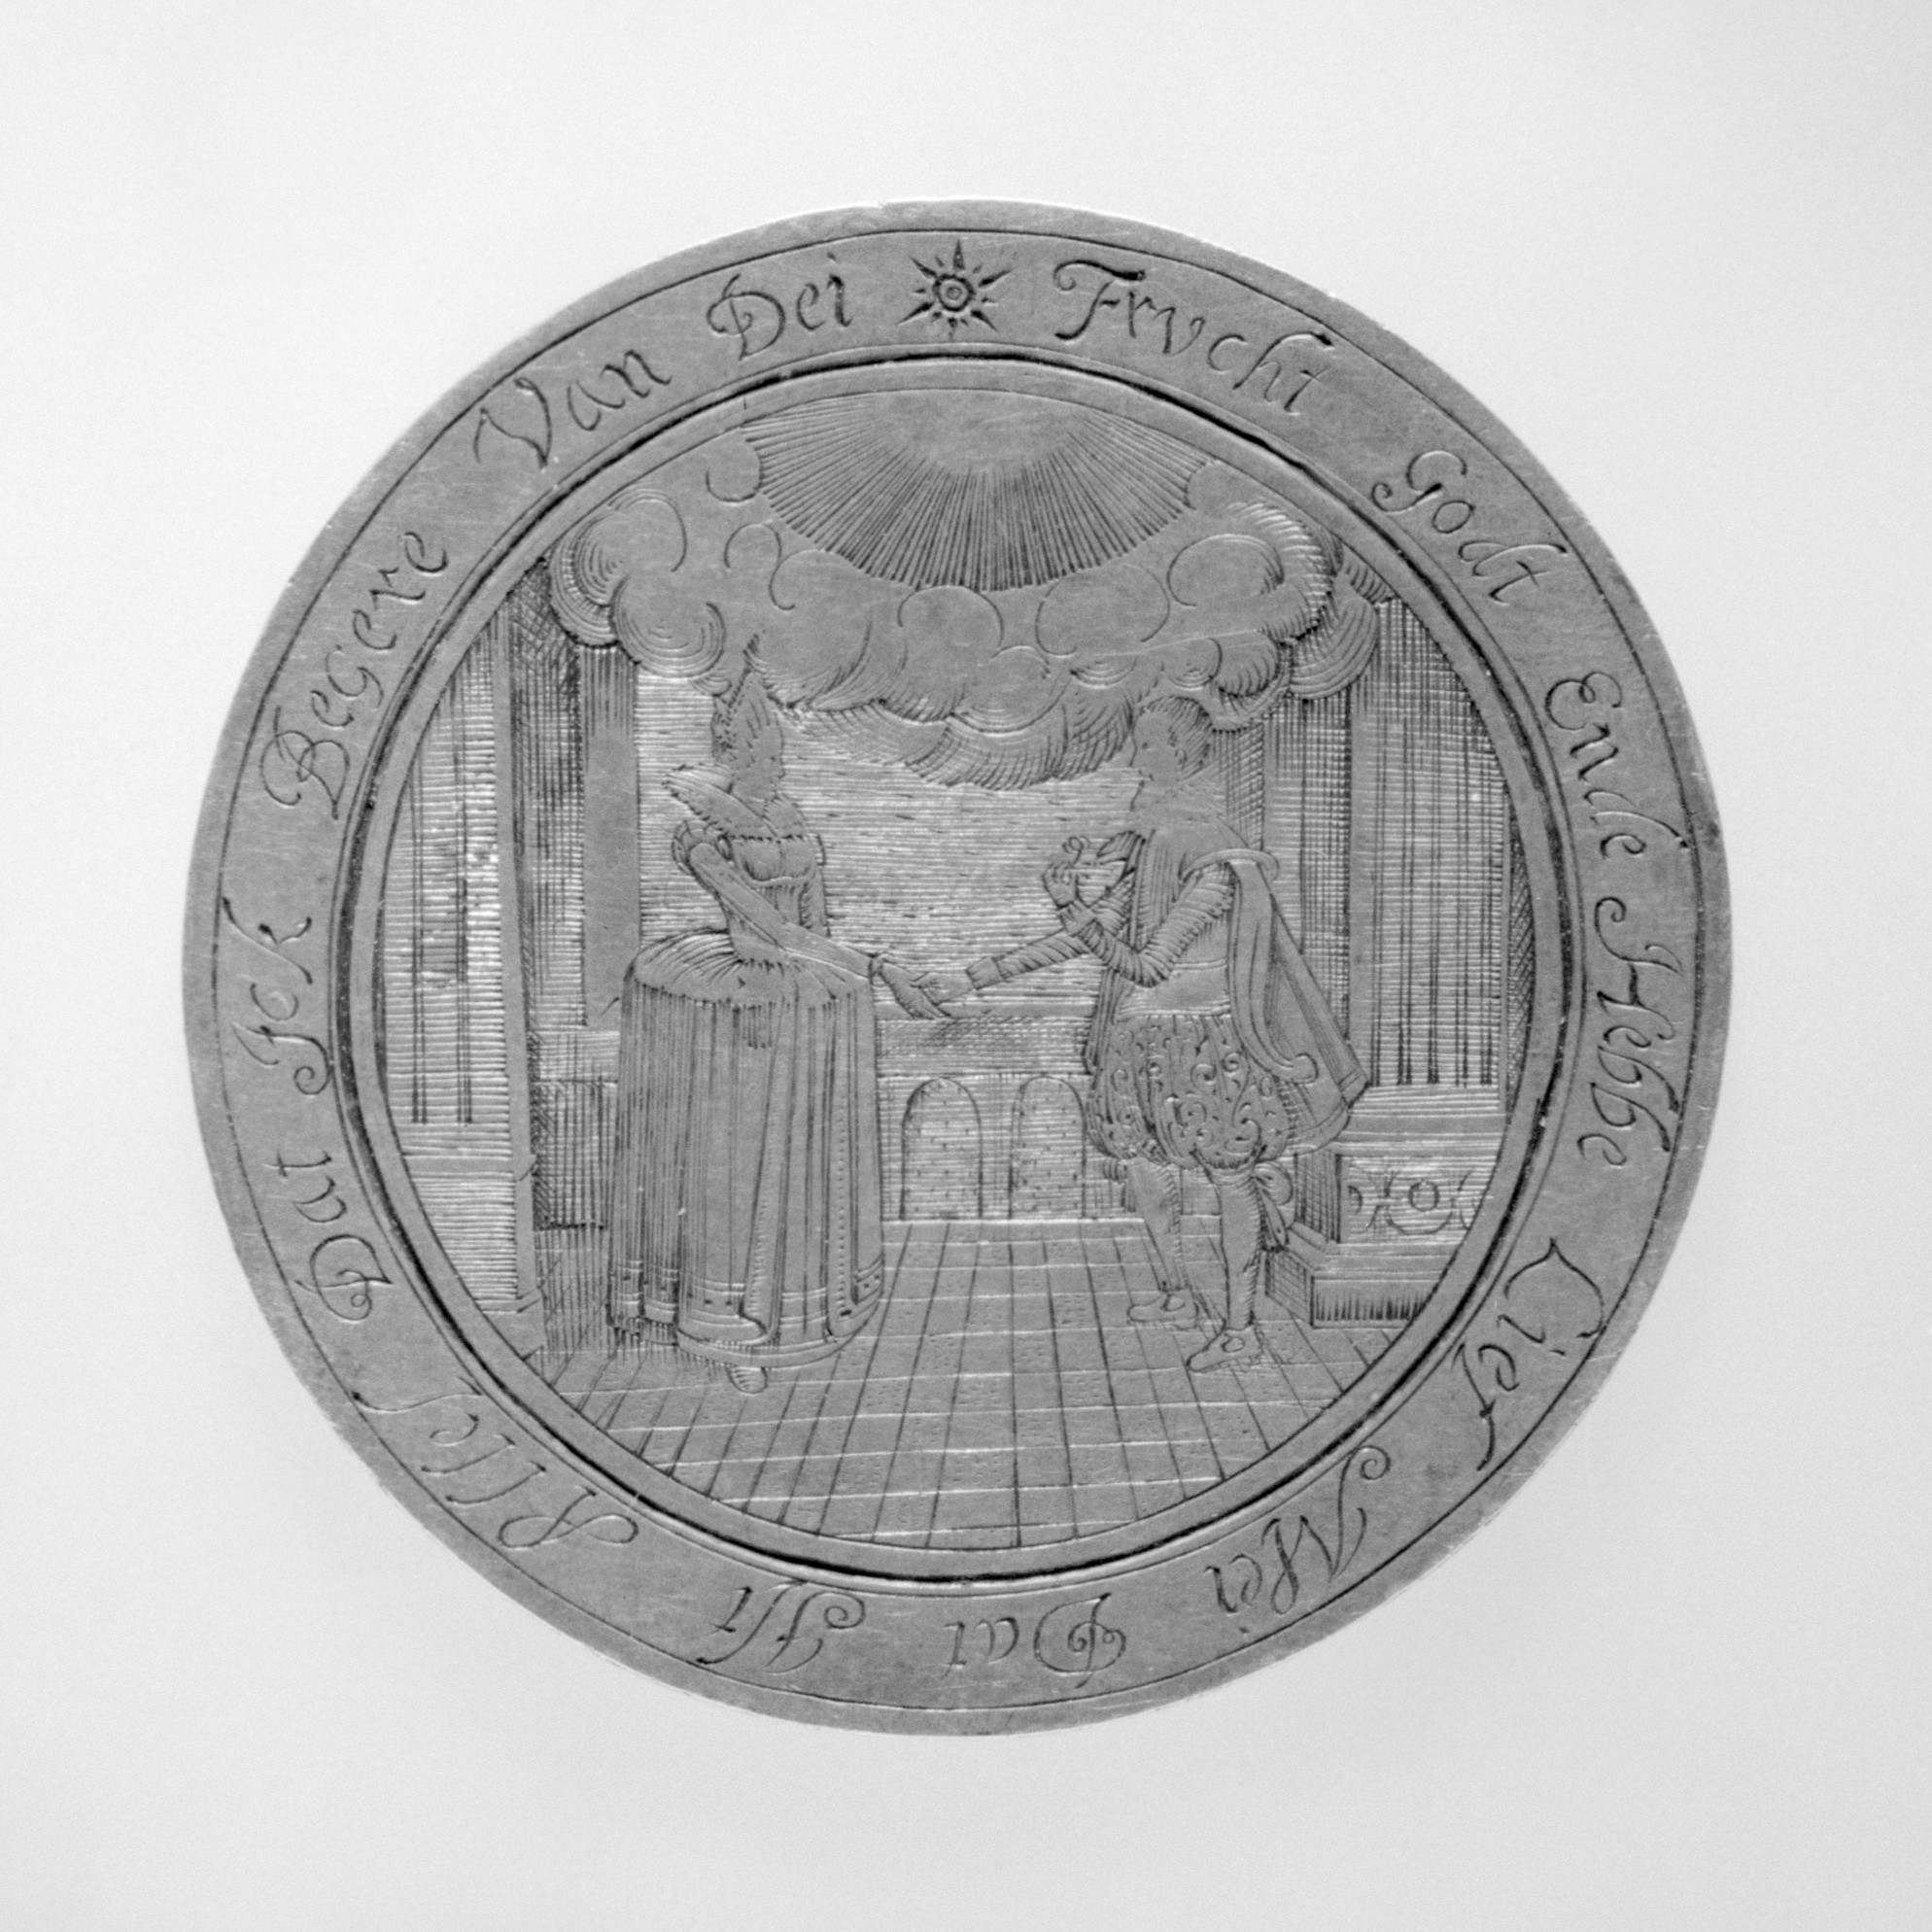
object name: medallion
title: Wedding medallion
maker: heinrich aldegrever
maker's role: artist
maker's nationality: german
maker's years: 1502-1561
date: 1600-1625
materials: silver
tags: men,women